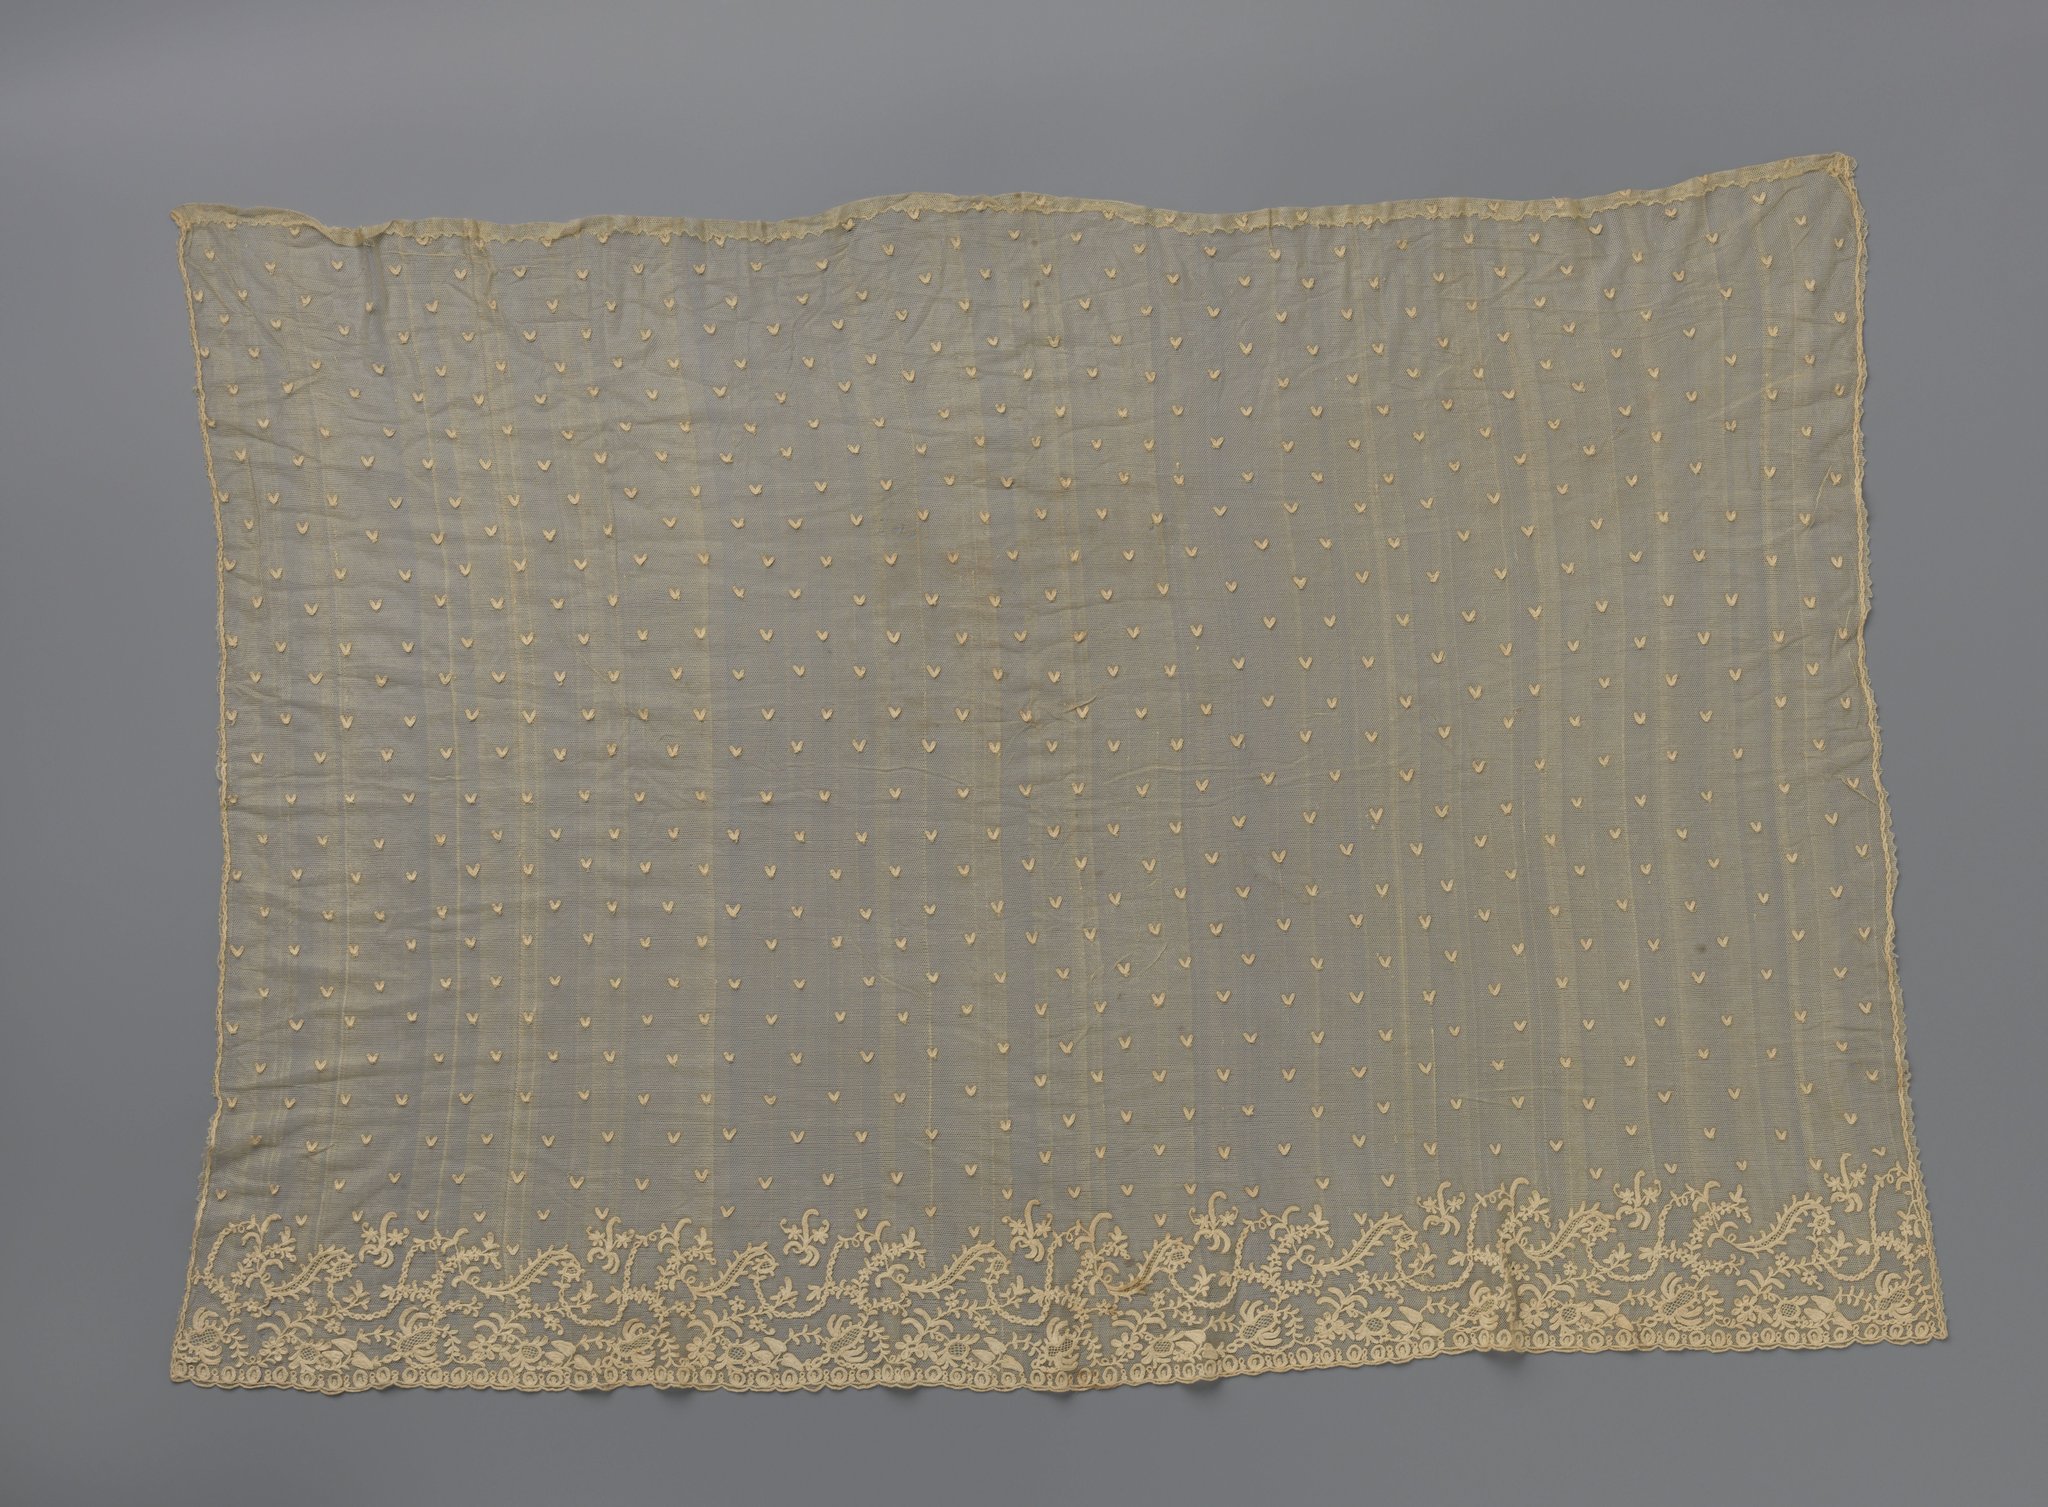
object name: apron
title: Schort van kantborduurwerk op tule voor een Zaans kostuum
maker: Anonymous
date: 1810-1824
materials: silk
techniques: lace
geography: limerick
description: Schort van naturelkleurig kantborduurwerk: Lierse kant of Limerick-kant (tamboereerwerk op tule). Rechthoekig model met een strooipatroon van v-tjes. Langs de onderrand een doorlopend patroon van een slinger en daaronder een golvende bloemenrank. De slinger bestaat uit een s-vormig parelsnoertje dat steeds wordt onderbroken door een langgerekt s-voluut. De bloemenrank bestaat uit grotere en kleinere bloemen, afwisselend rozetvormig, rond en in de vorm van een ingeknepen ovaal. Zijtakjes oversnijden de slinger erboven. De flauw geschulpte onderrand vormt zich langs het onderste deel van patroon dat bestaat uit een doorlopende lijn, die in een rechte rij afwisselend ovale lussen en kleine achtjes vormt. De zijkanten van het tule zijn gevormd in puntige schulpjes, waarlangs met tamboereerwerk twee om elkaar heen slingerende lijnen lopen. De bovenzijde is afgewerkt met een zoompje waar een lintje doorheen past. Eén soort siergrond komt voor in de bloemharten en de s-voluten.